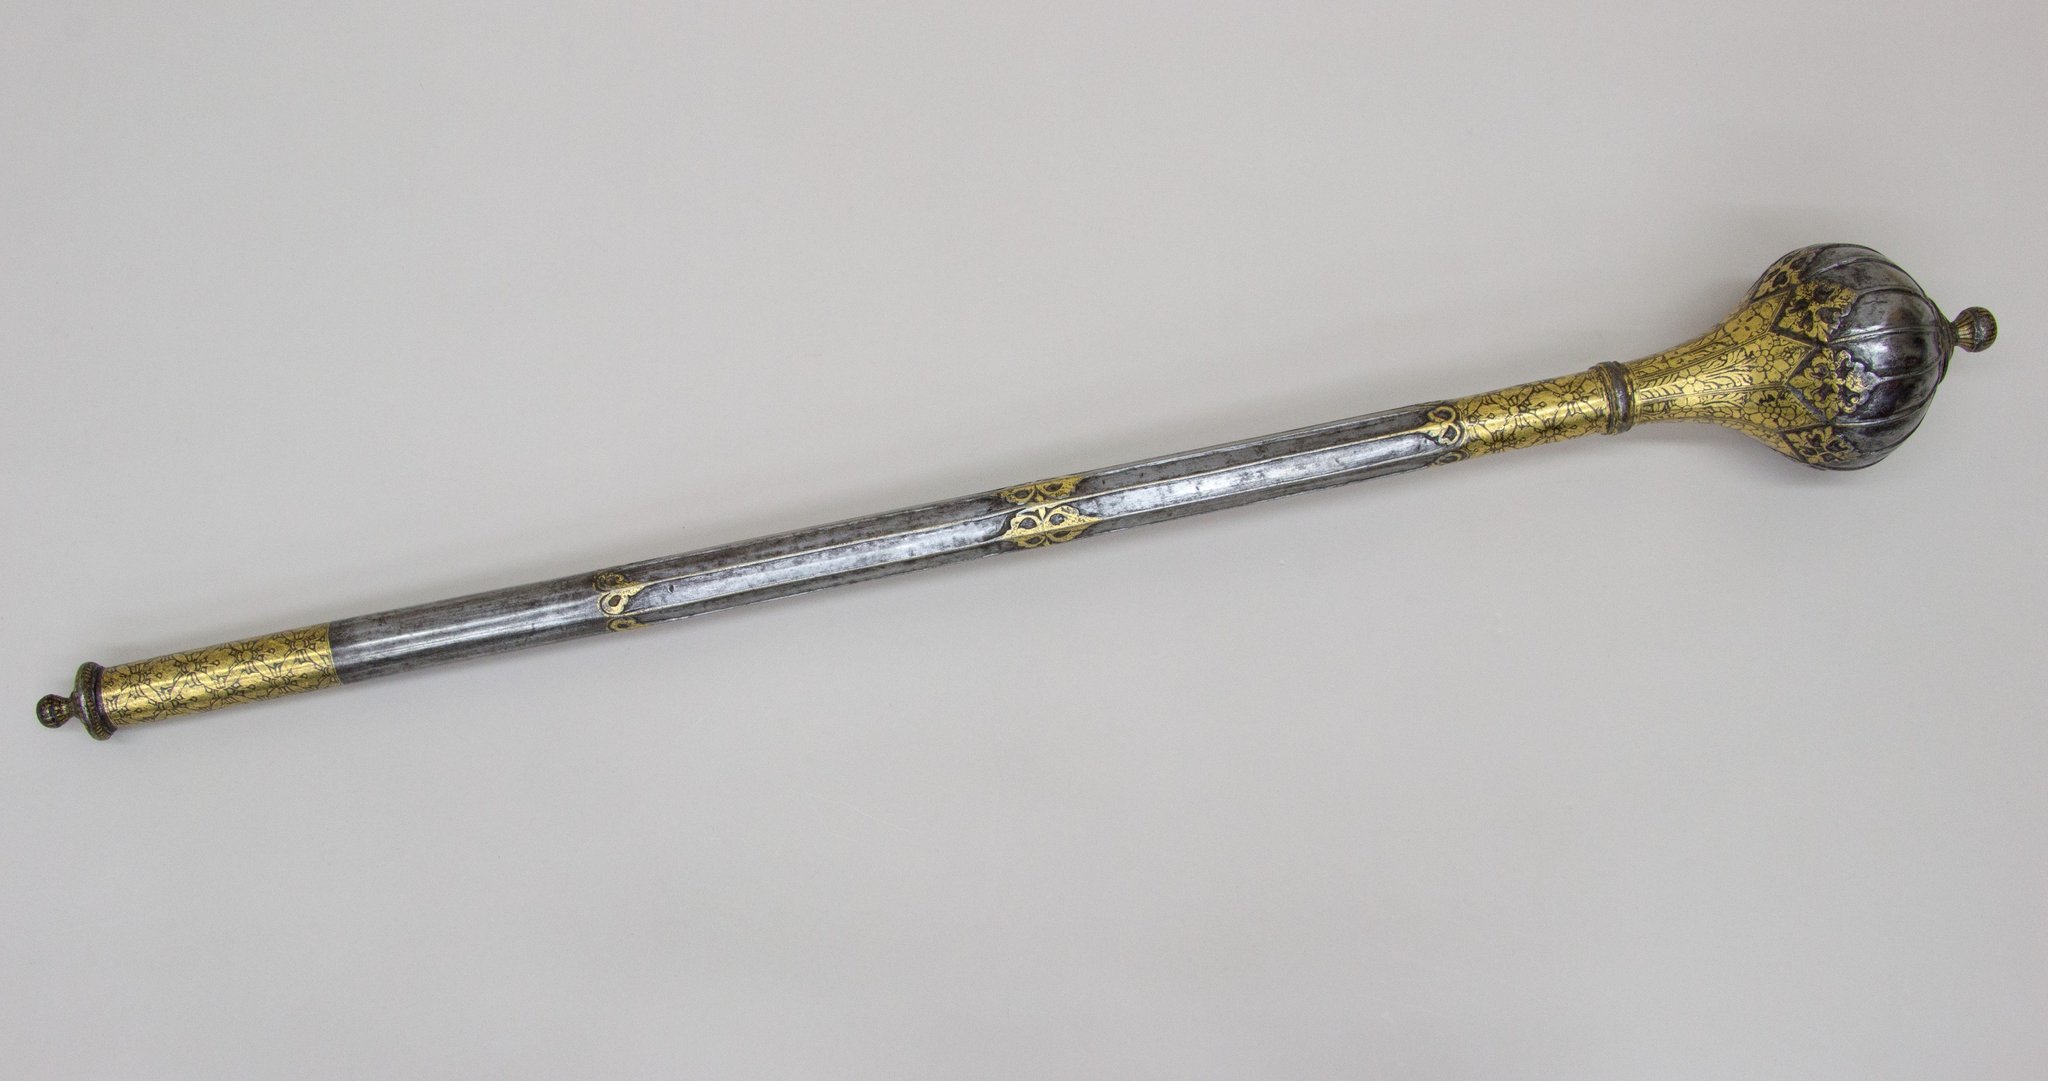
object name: mace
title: Mace (Gada)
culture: indo-persian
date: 1601-1700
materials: gold, steel